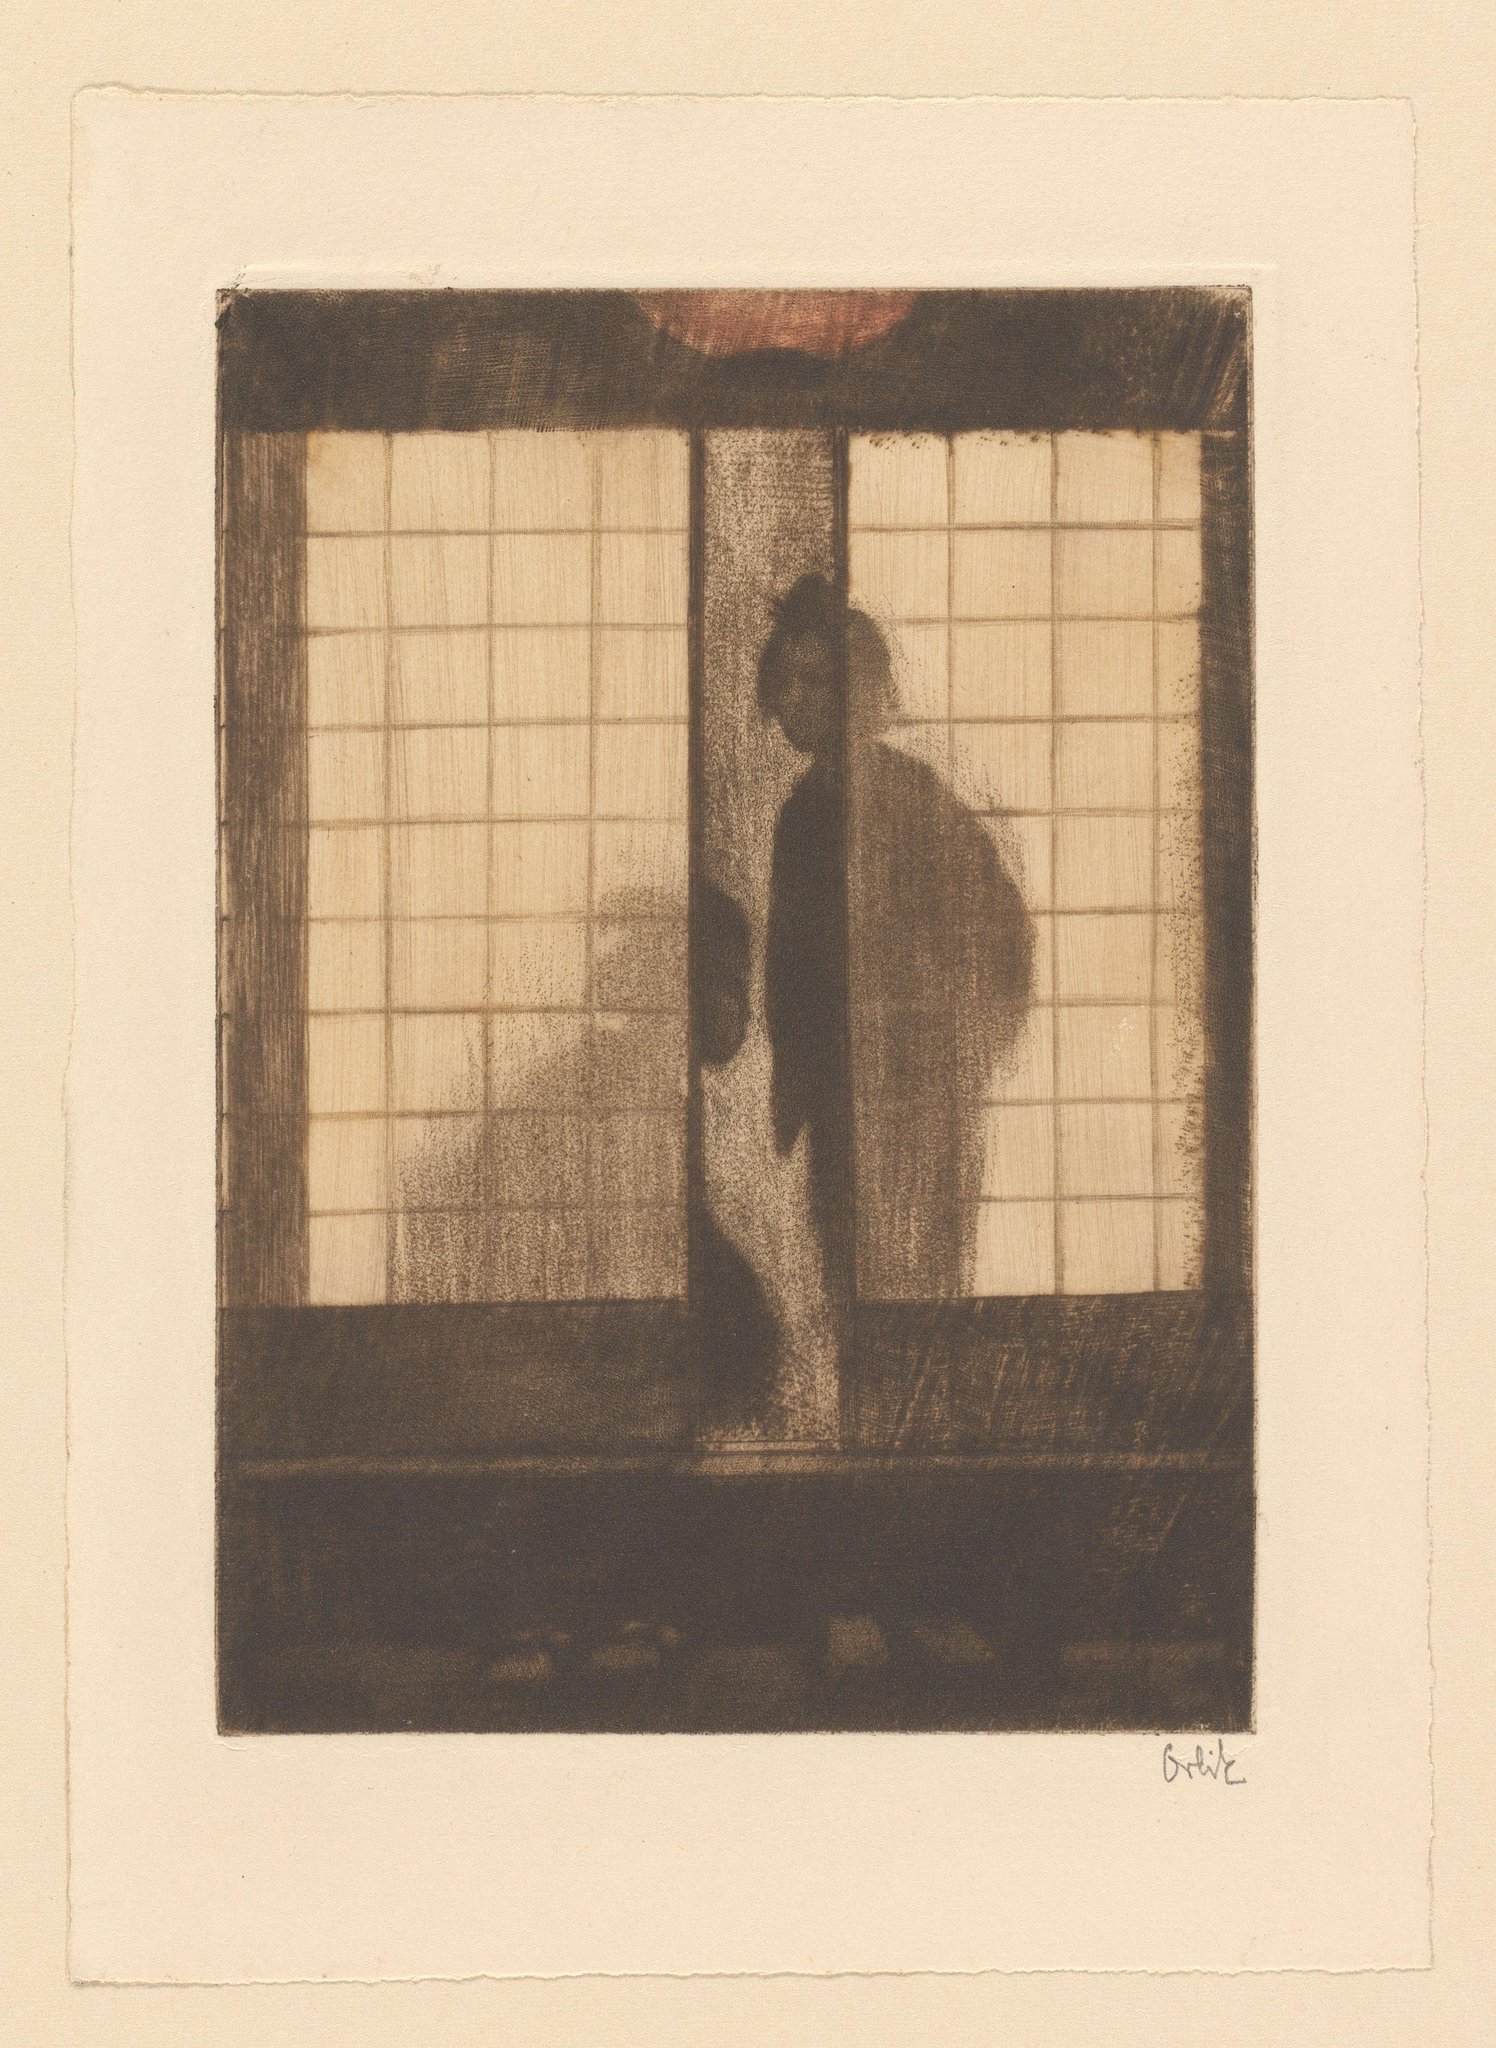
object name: print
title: Aus Japan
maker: emil orlik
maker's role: painter, print maker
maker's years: 1870-1932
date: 1901-1903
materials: paper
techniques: etching, roulette, soft ground etching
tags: open door, night, japan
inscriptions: collector's mark: Lugt 2228